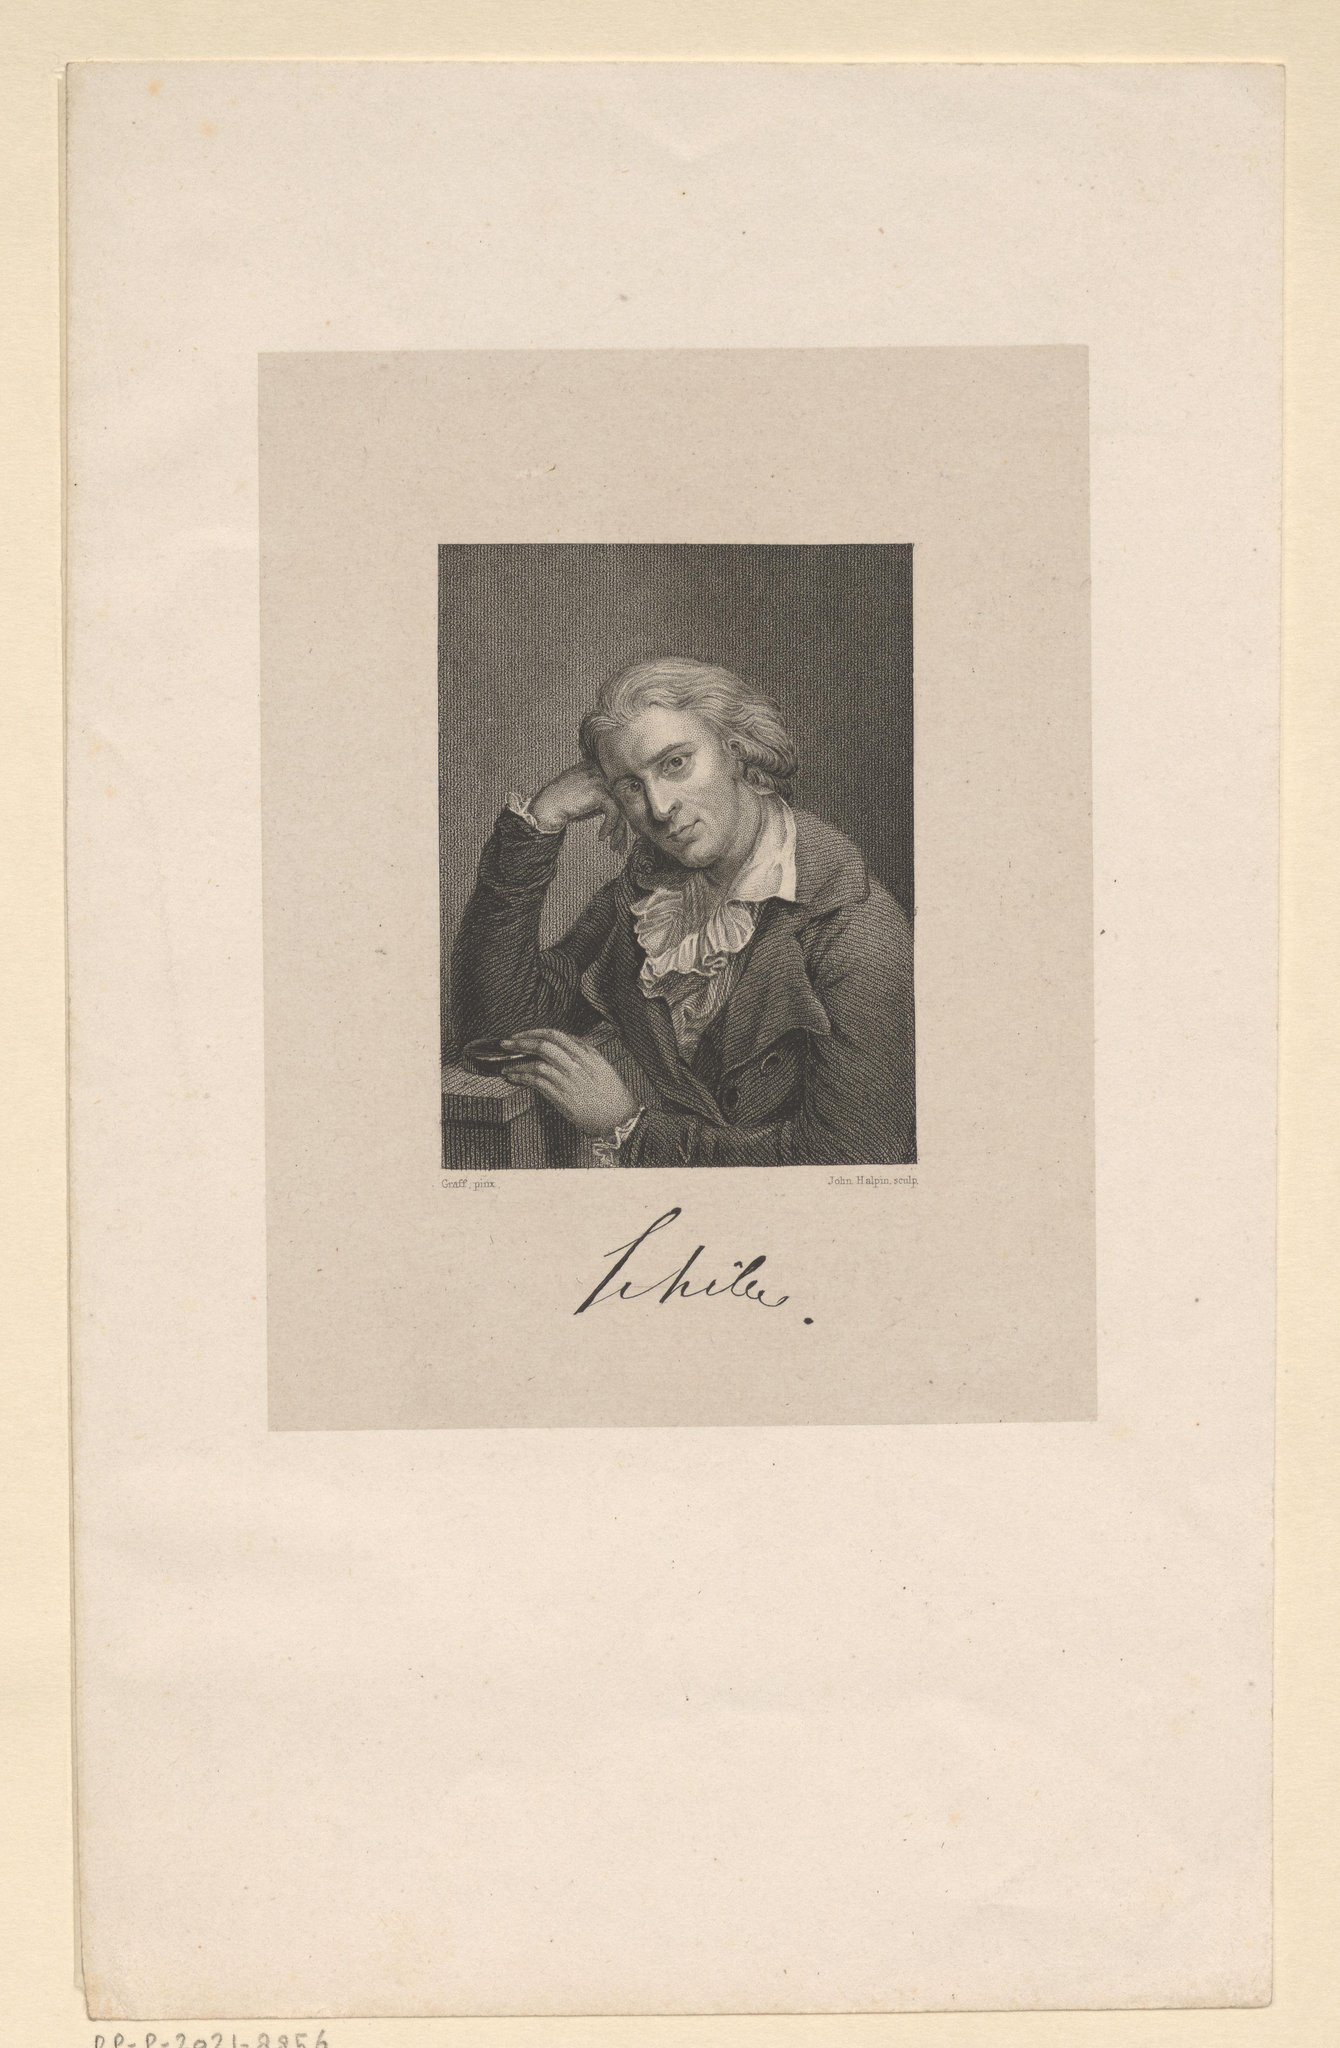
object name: print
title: Portret van Friedrich von Schiller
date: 1800-1849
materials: paper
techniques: engraving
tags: friedrich von schiller, scholar, philosopher, historical persons, portrait of a writer